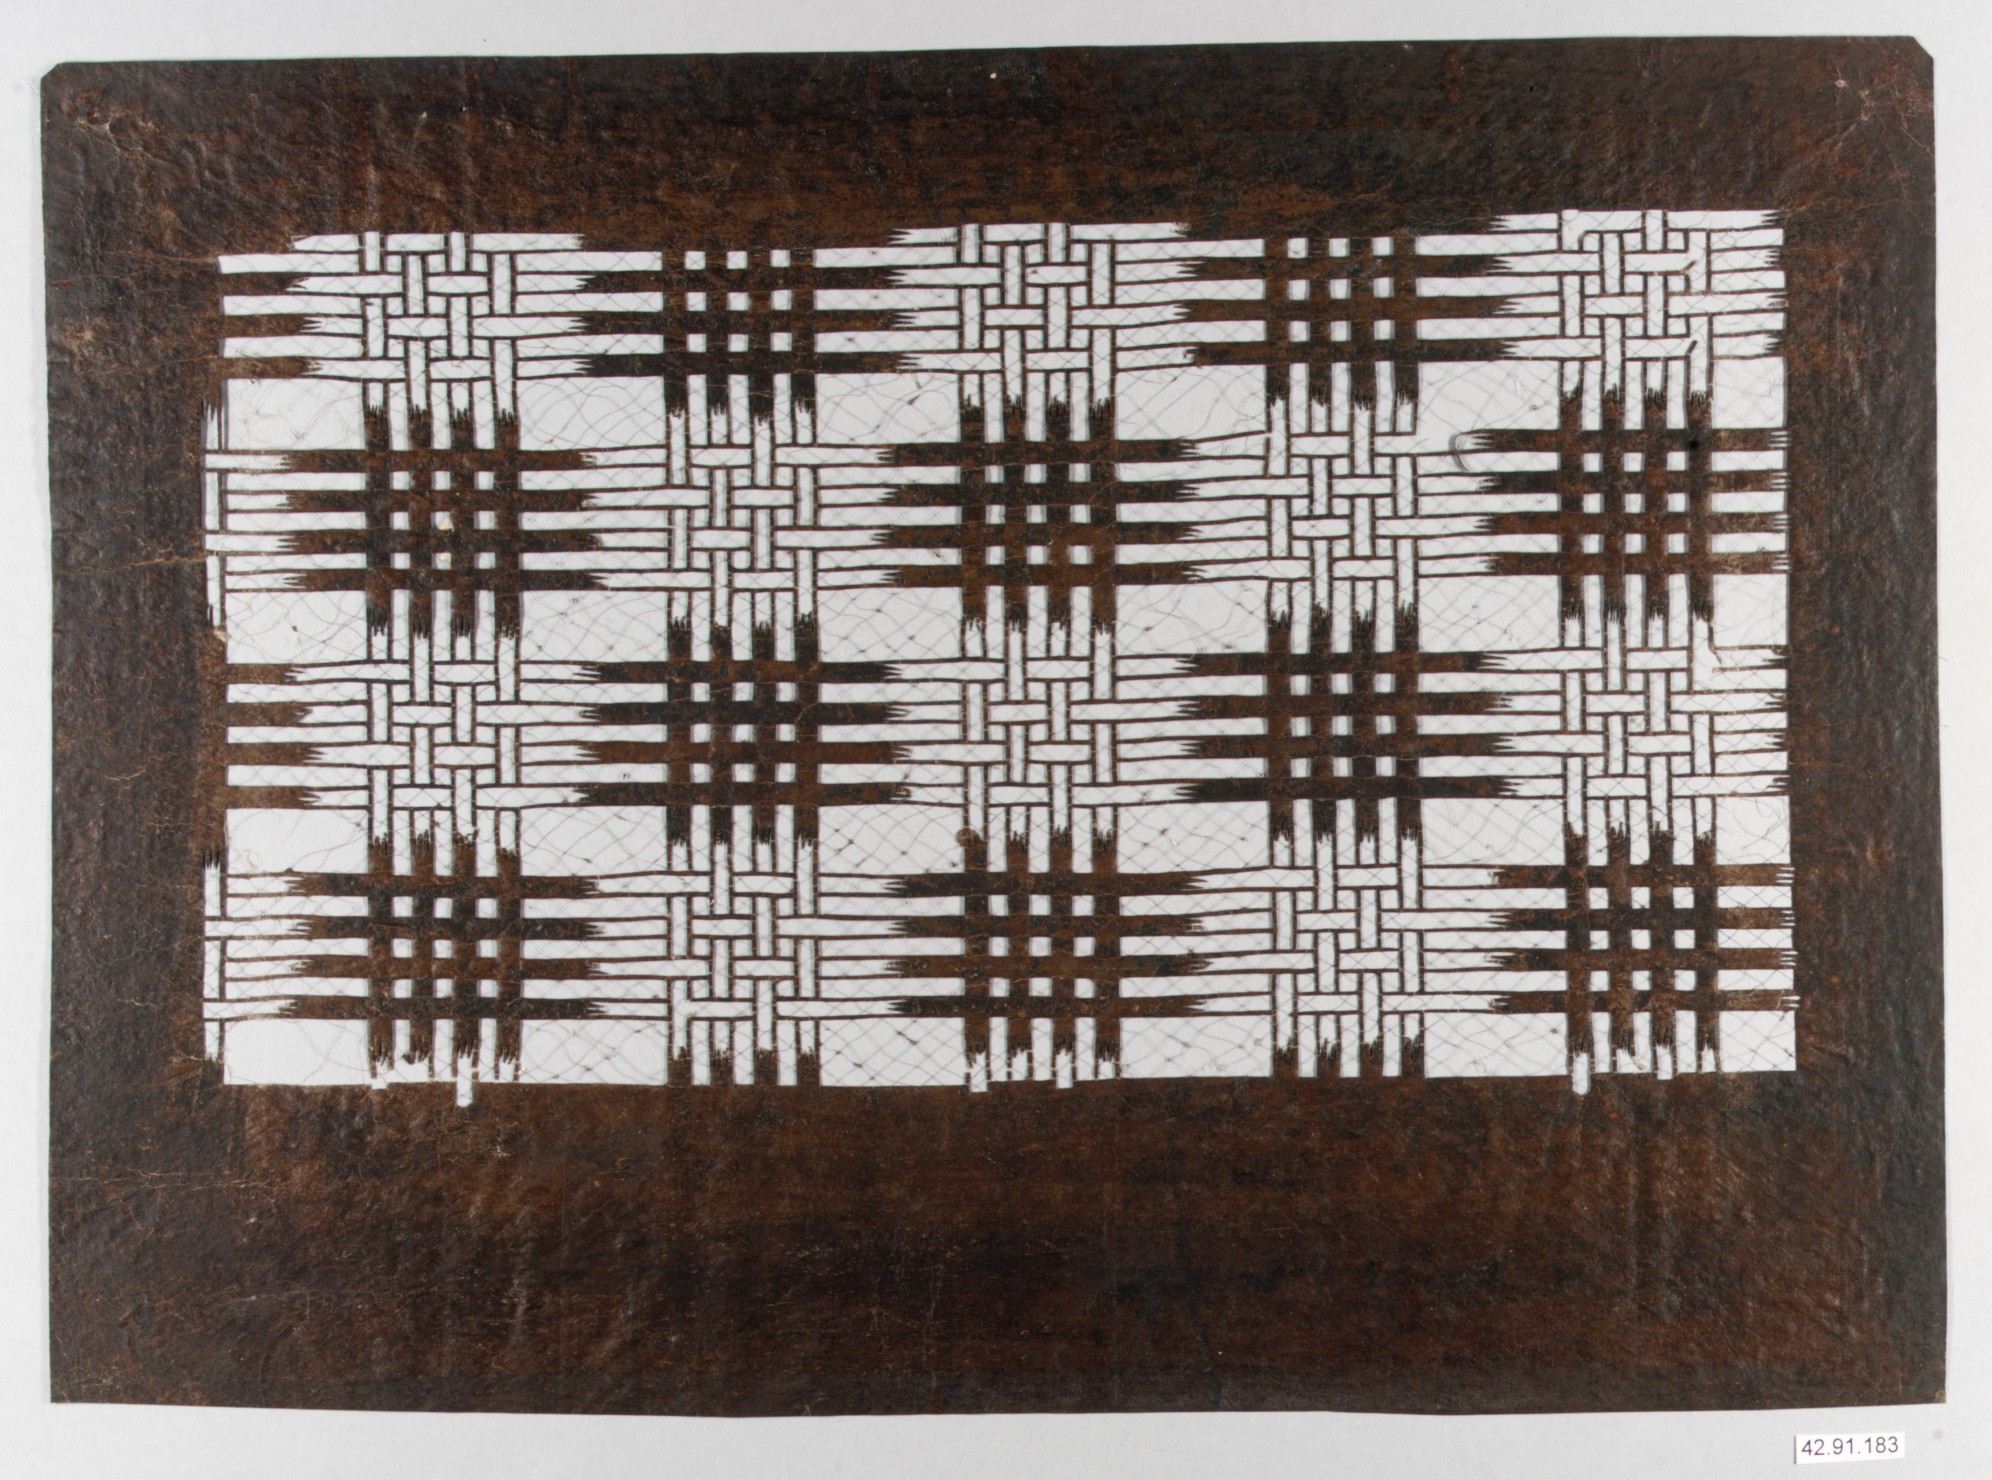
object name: stencil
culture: japanese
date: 1801-1900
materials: paper, silk